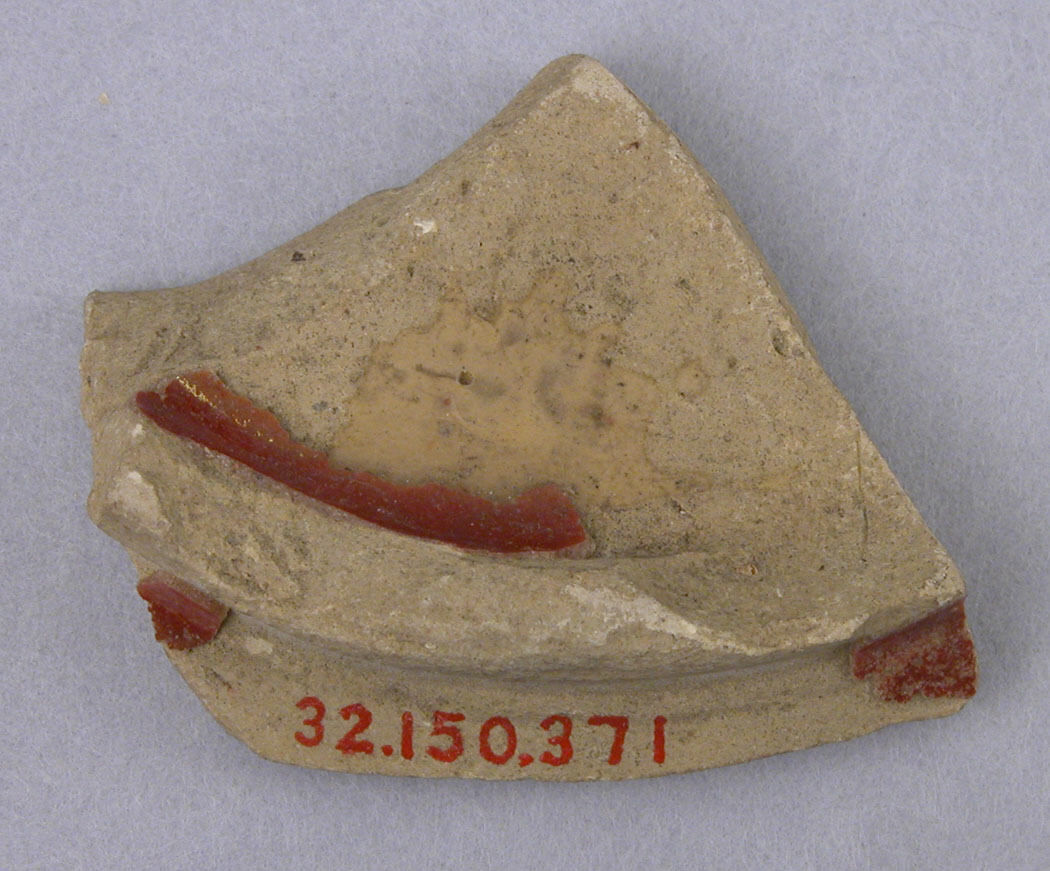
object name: fragment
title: Ceramic Fragment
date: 701-900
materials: earthenware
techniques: glazing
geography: iraq